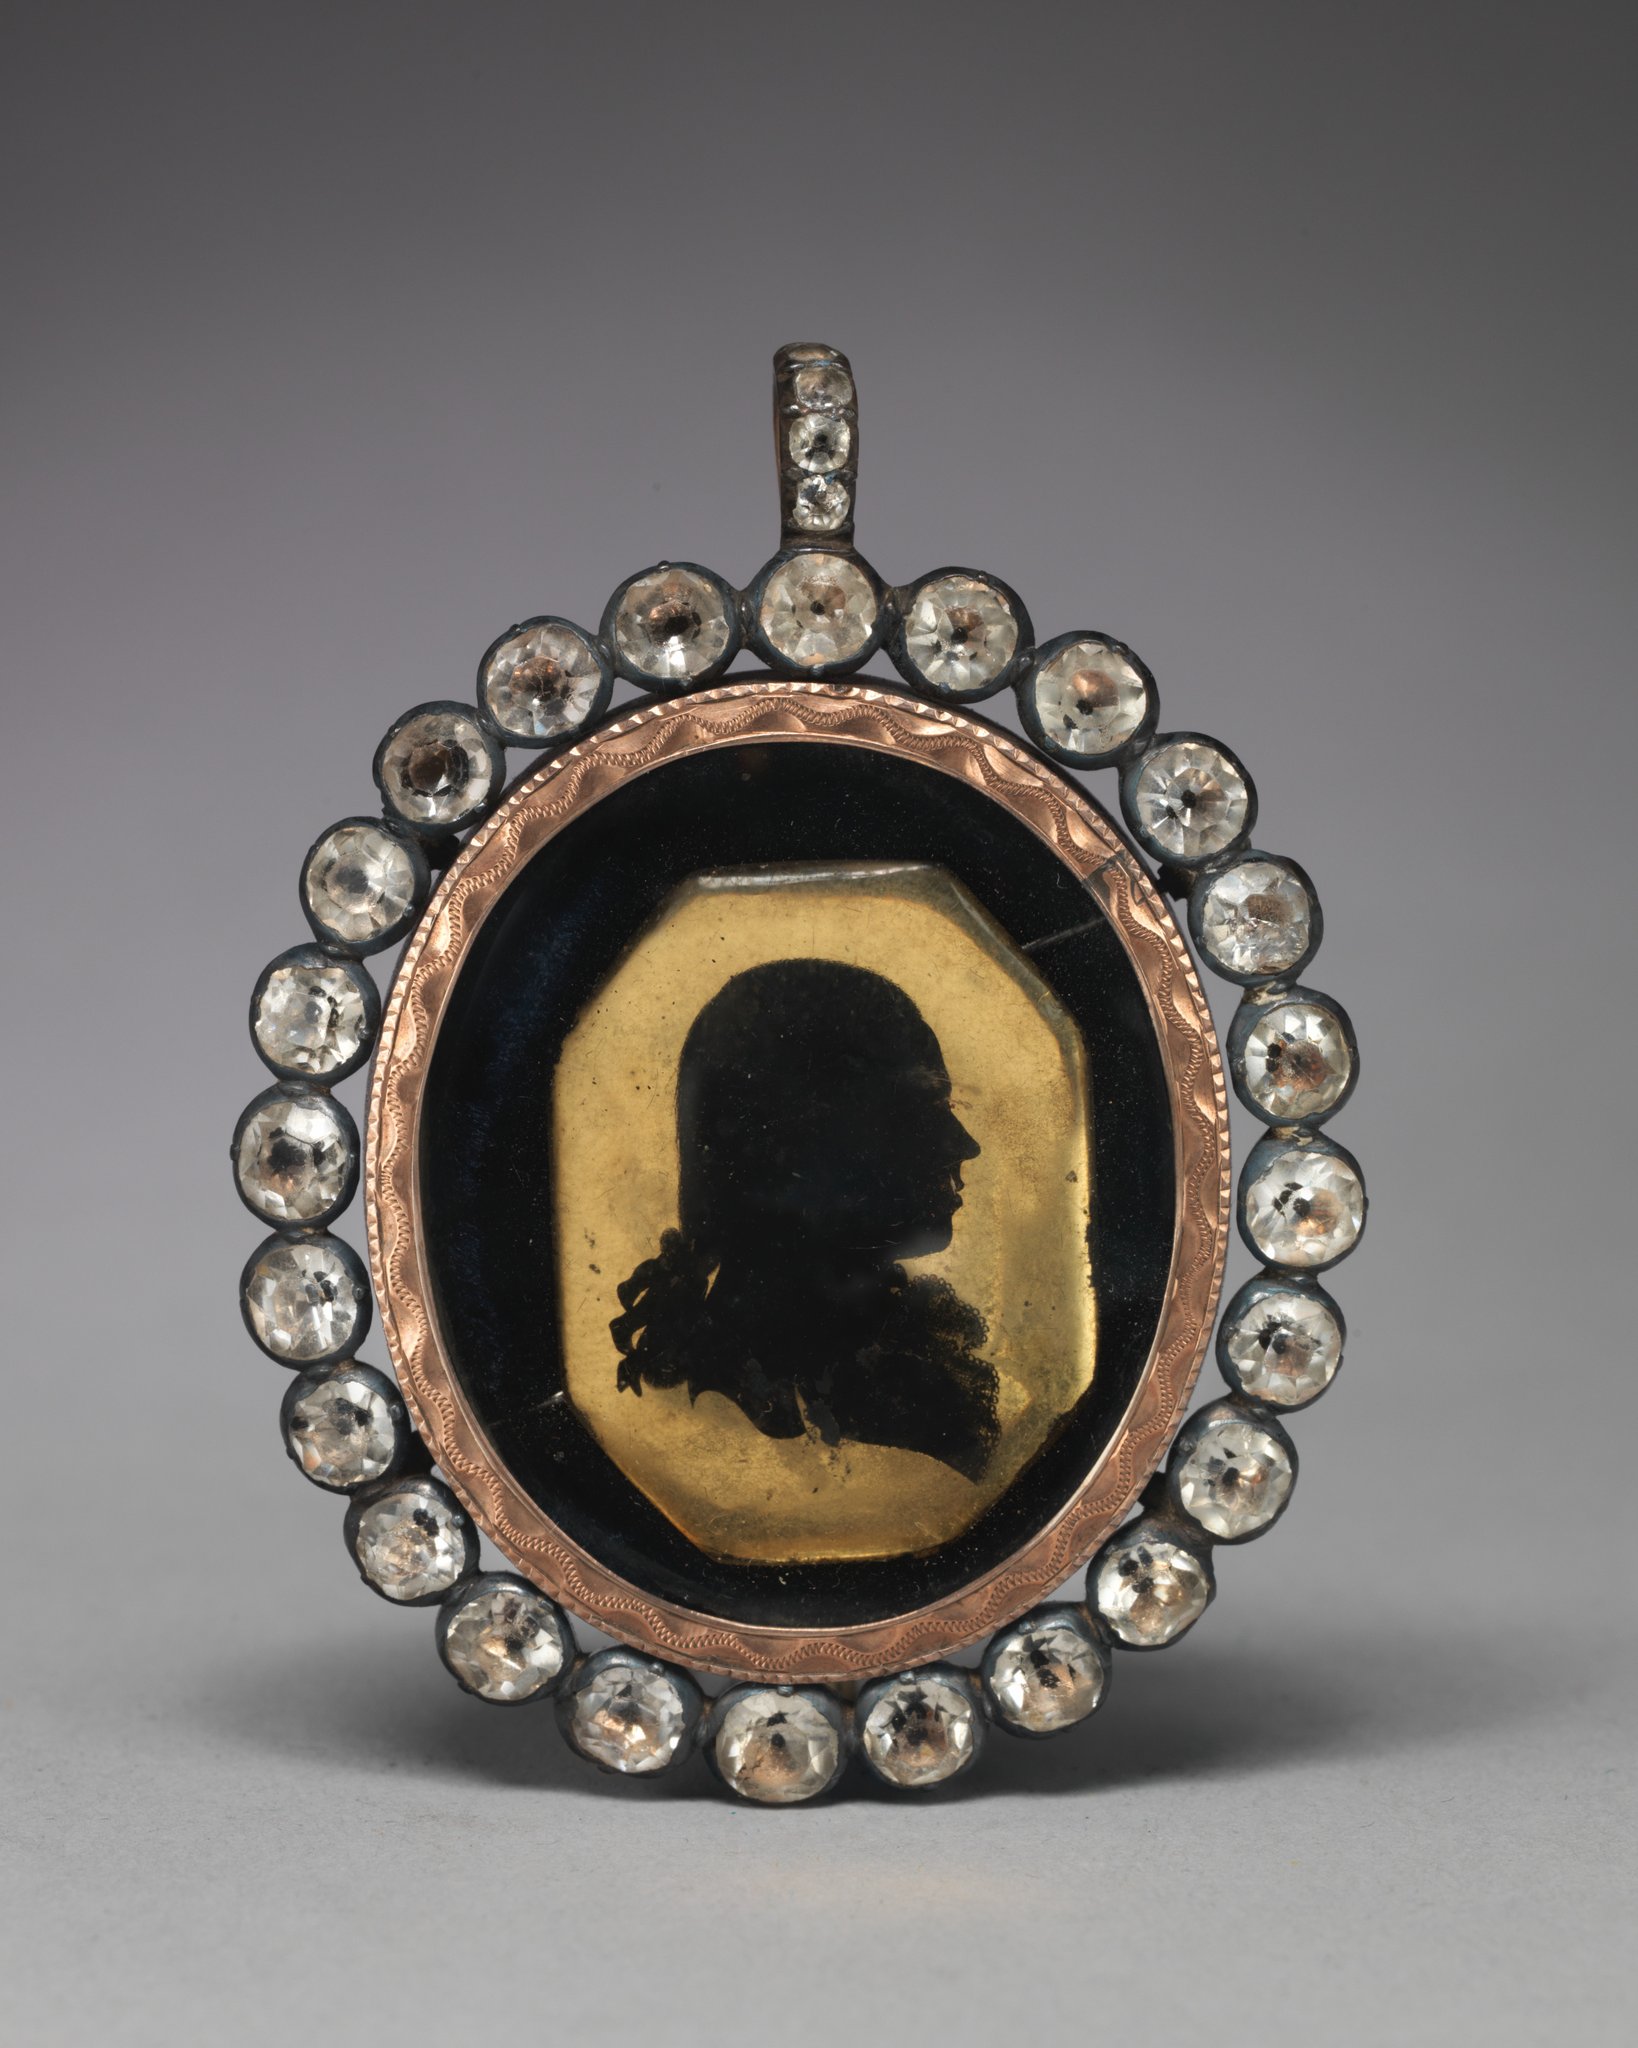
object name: pendant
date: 1701-1800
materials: copper, glass, silk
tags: men,profiles